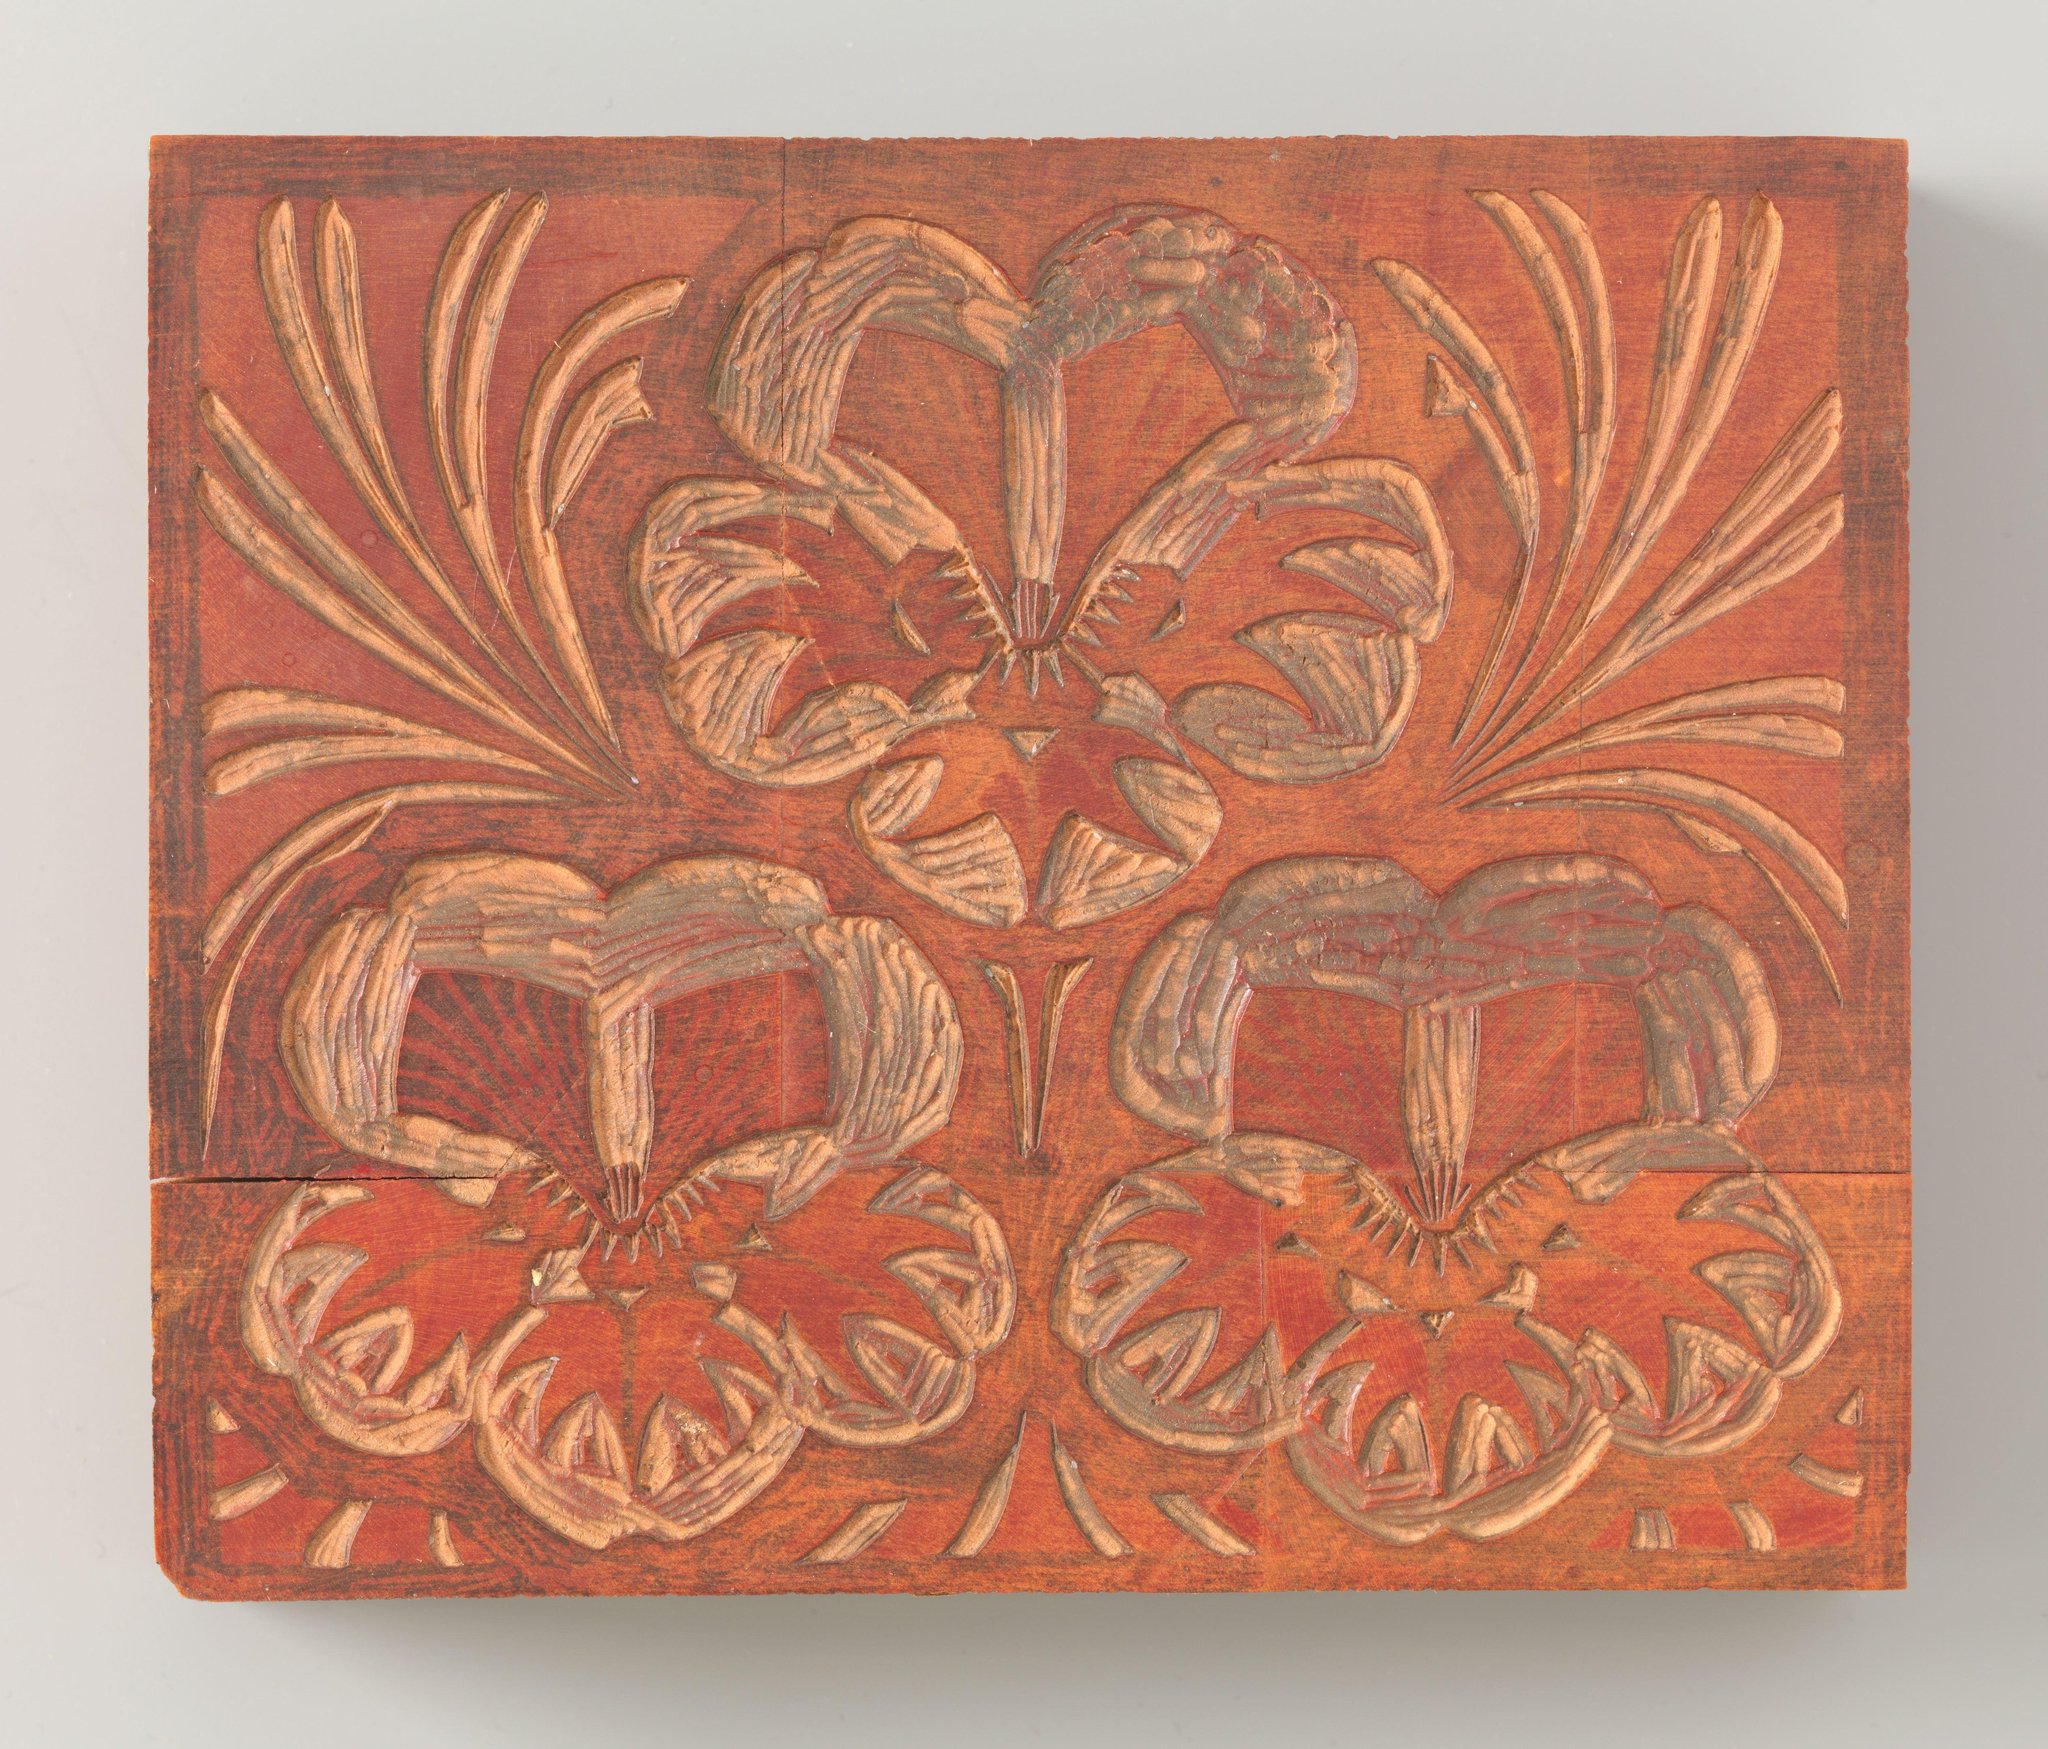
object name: houtblok kopshout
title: Drie bloemen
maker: julie de graag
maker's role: draughtsman, print maker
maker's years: 1877-1924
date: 1919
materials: wood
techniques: woodcut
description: Het blok is gesneden voor een kleurendruk.